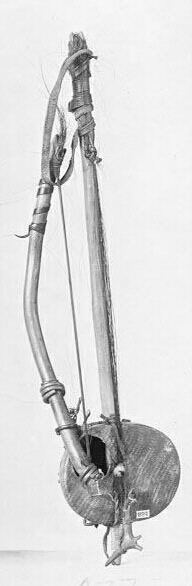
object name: koumdyeh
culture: sarakole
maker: sarakole people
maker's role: maker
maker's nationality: sierra leone, africa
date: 1867-1900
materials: brass, copper, hair, leather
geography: sierra leone